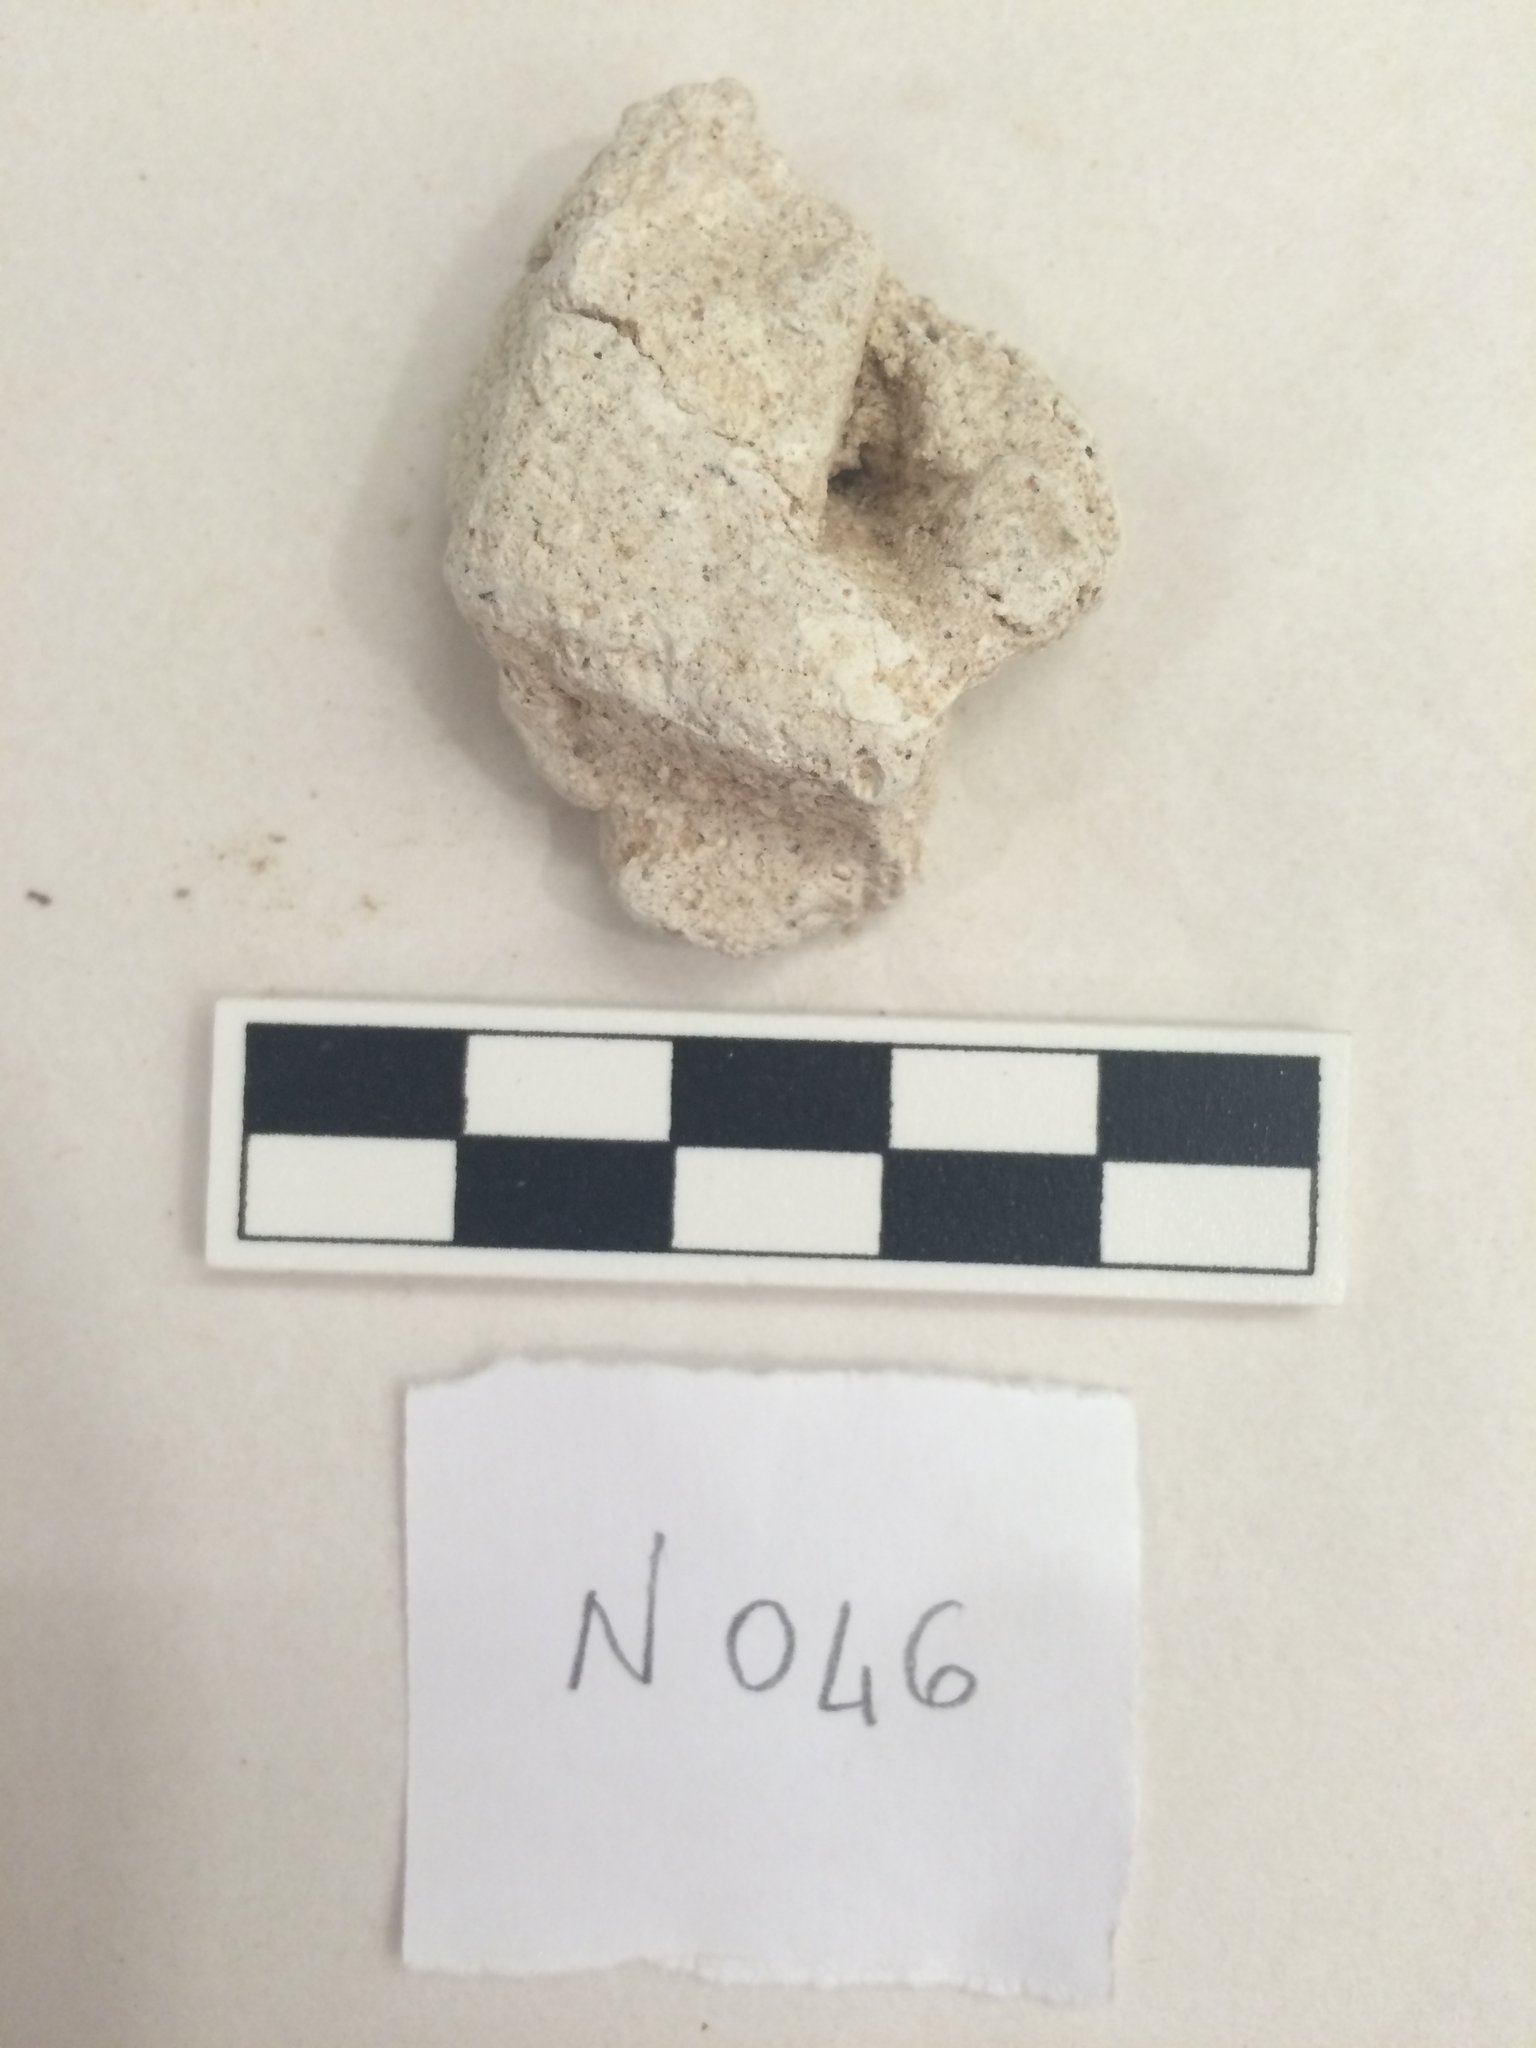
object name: fragment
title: Stucco Fragment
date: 701-1200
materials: plaster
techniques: carving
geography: iran